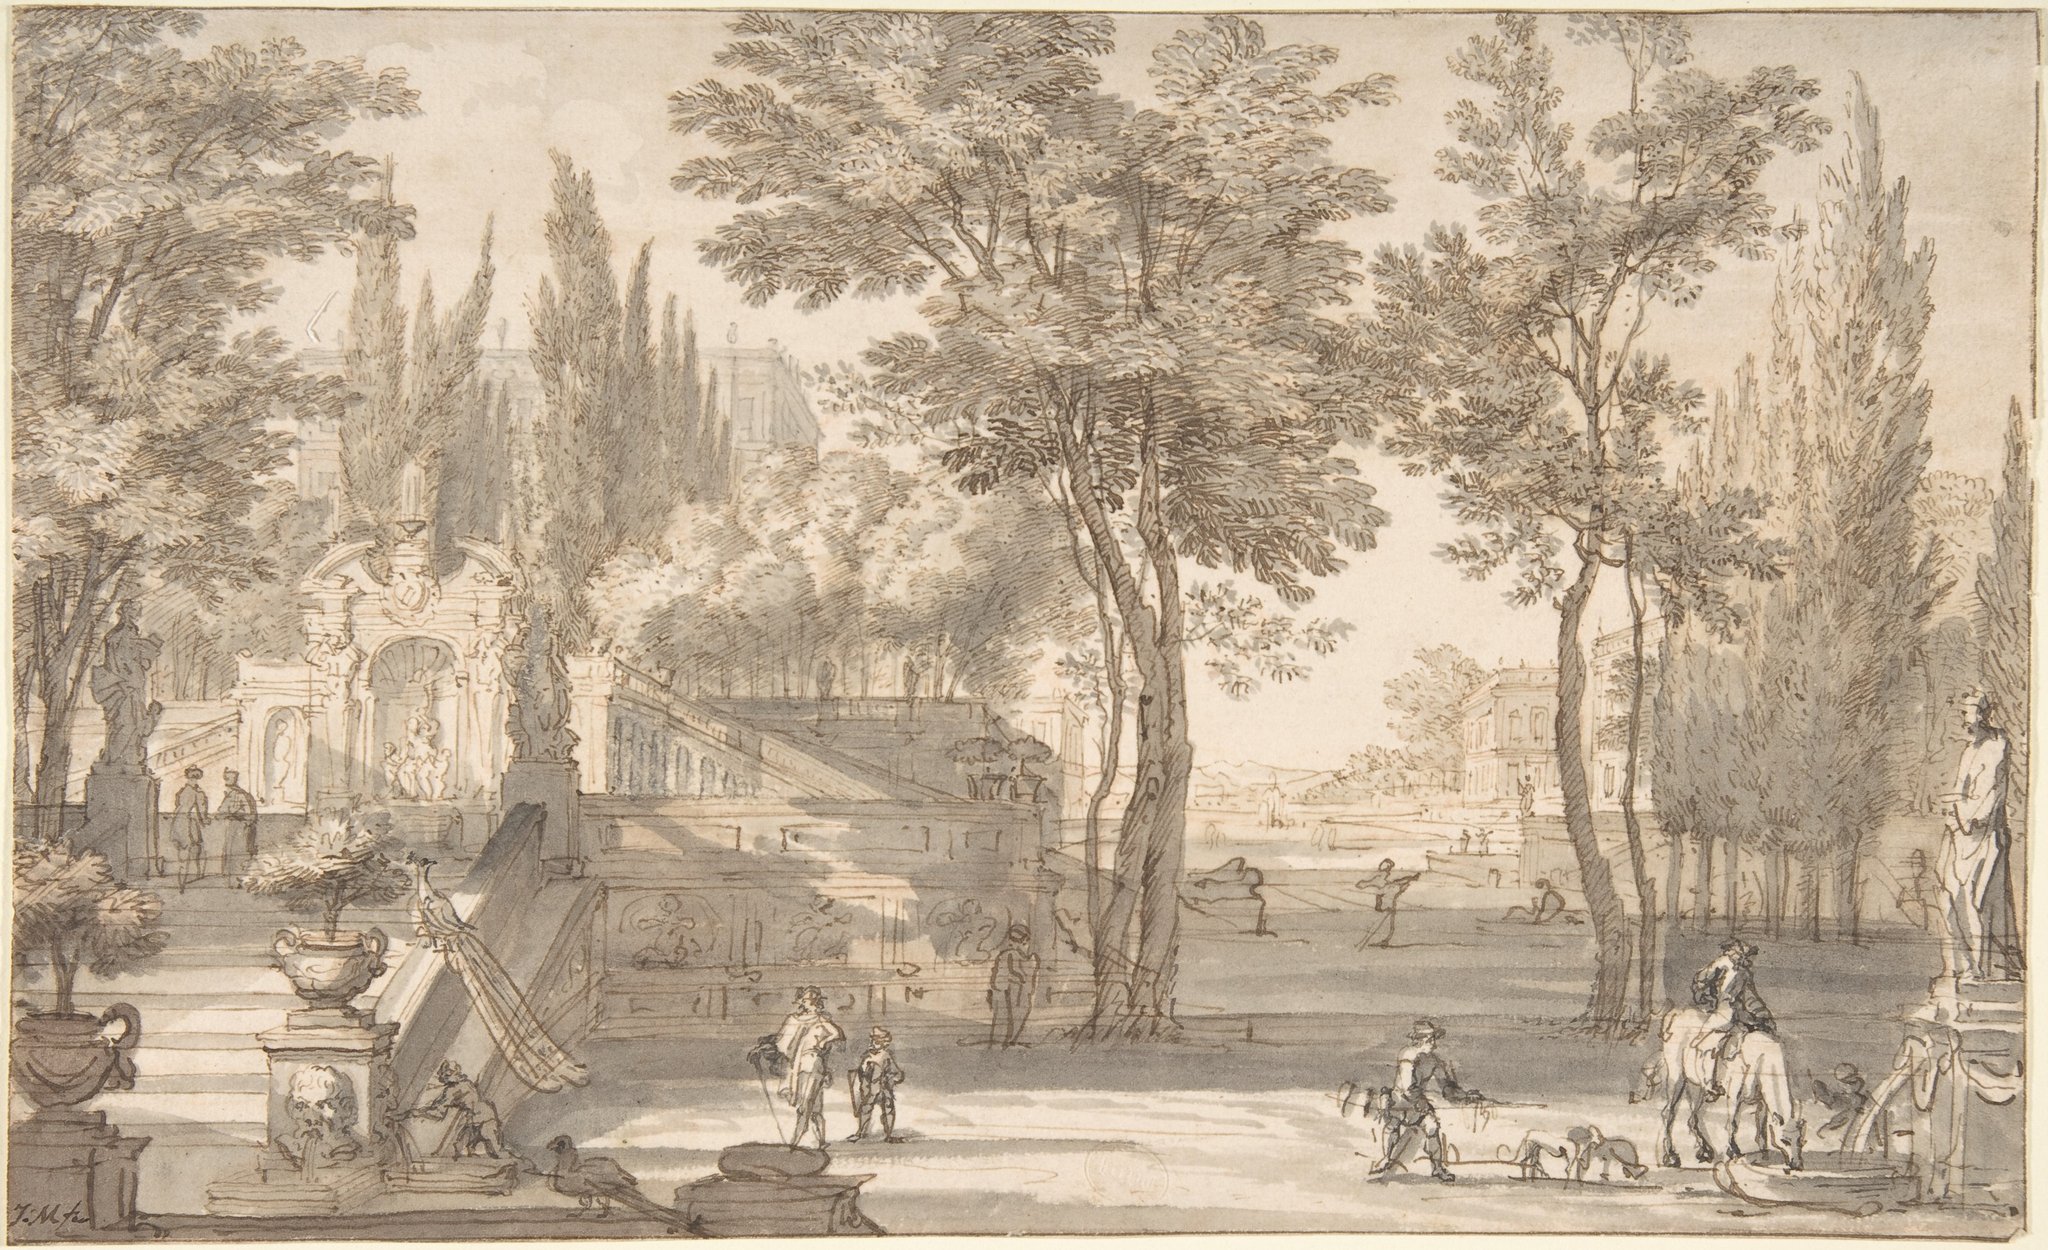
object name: drawing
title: Classical Landscape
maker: isaac de moucheron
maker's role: artist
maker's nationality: dutch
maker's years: 1667-1744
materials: ink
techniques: brush, pen, wash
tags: human figures,buildings,peacocks,landscapes,trees